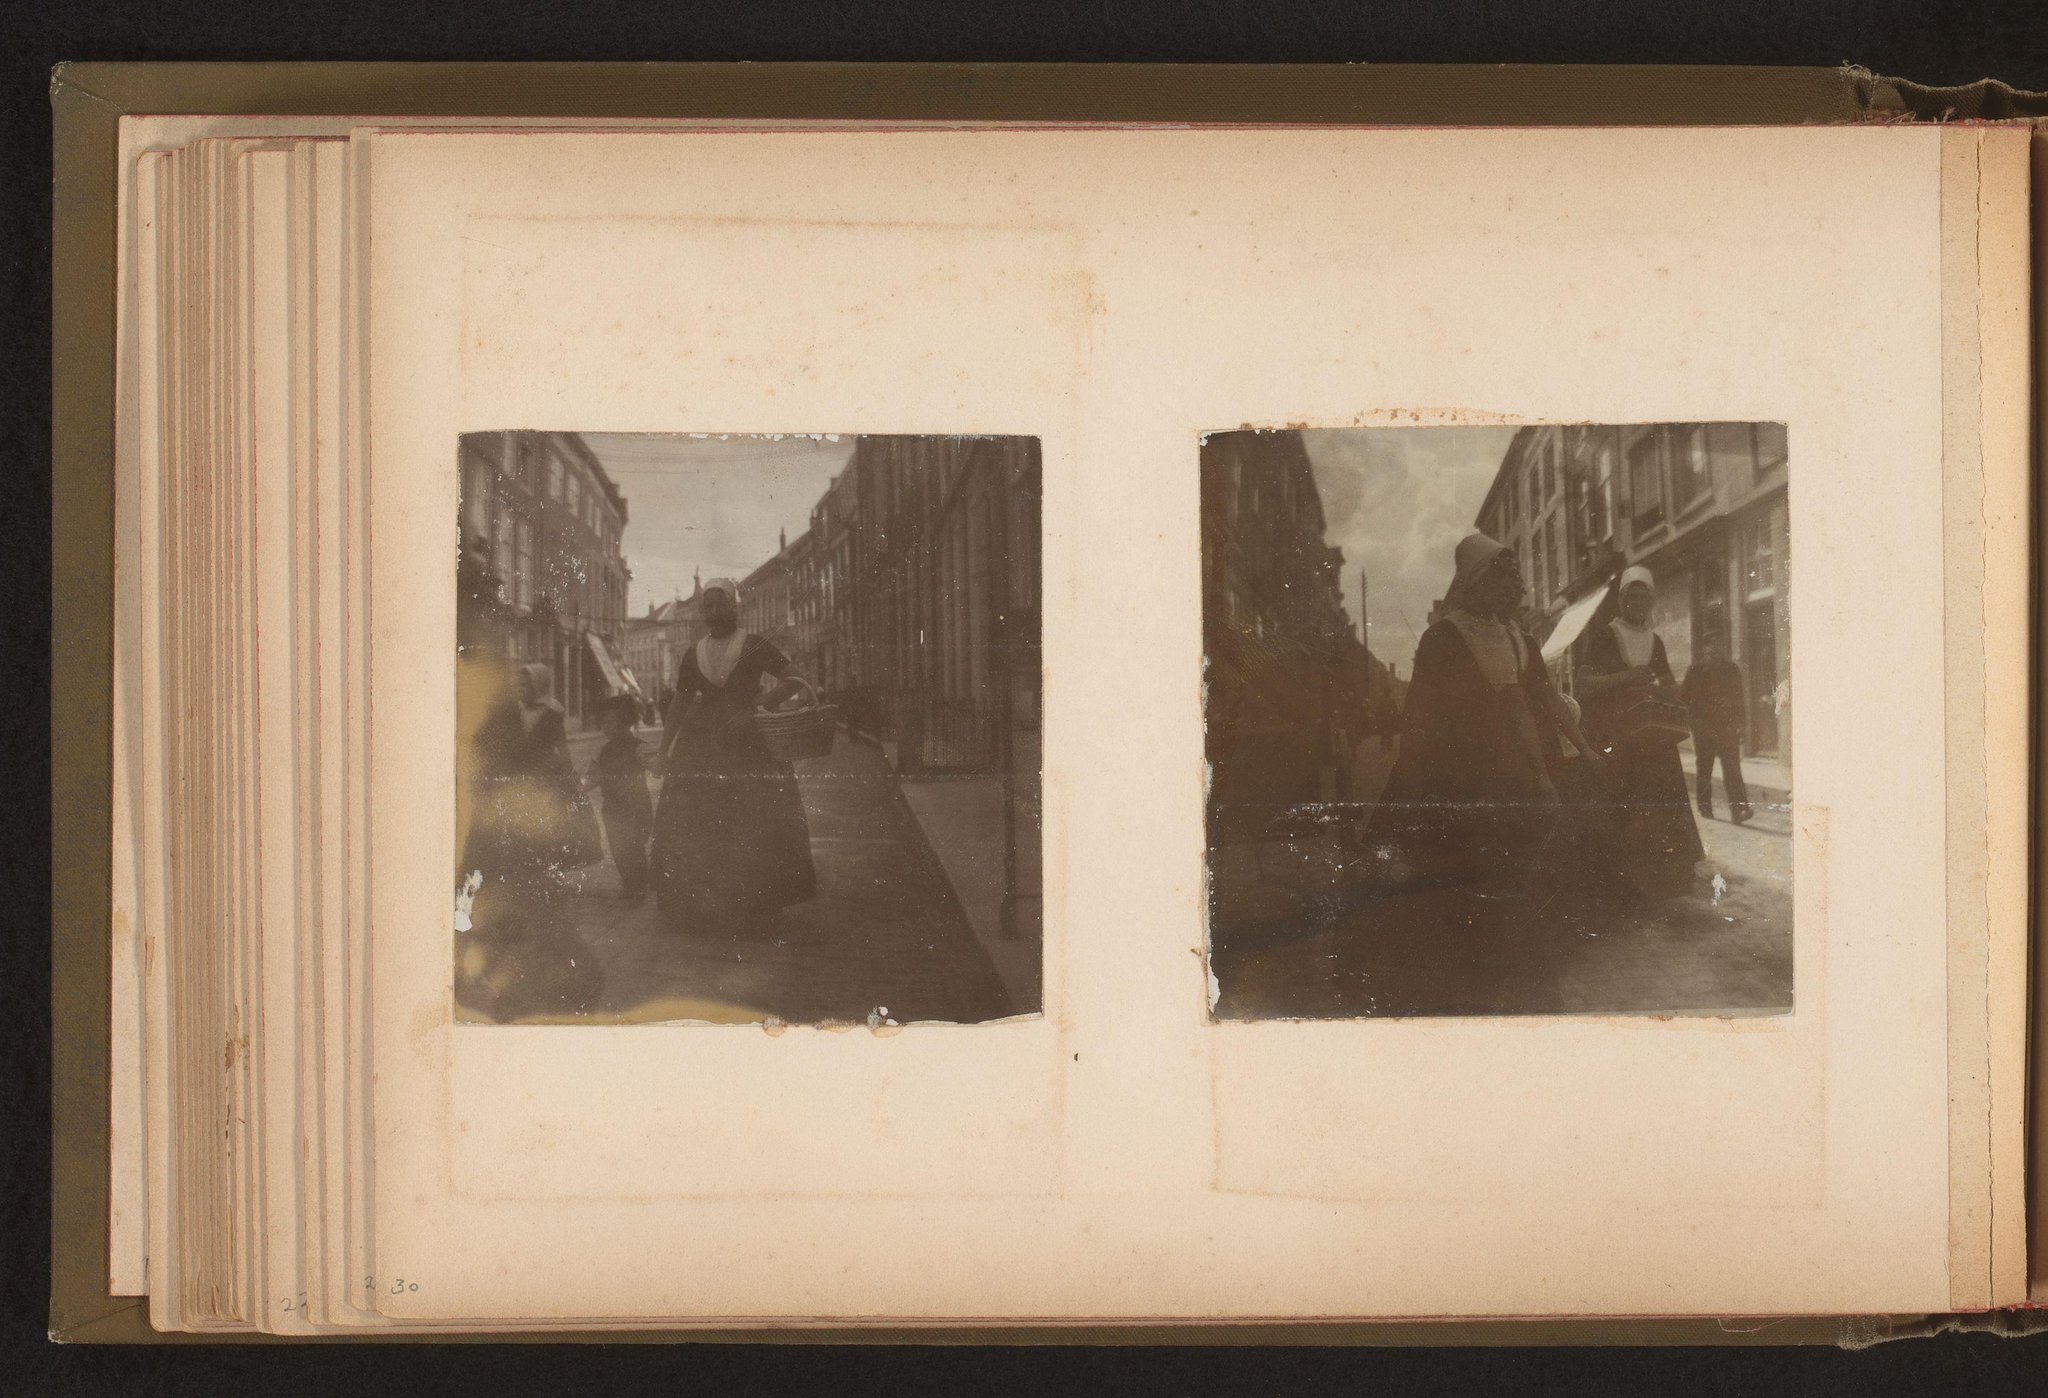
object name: album leaf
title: Twee foto's van vrouwen in klederdracht op straat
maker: Anonymous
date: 1895-1910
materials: paper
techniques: collodion silver print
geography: netherlands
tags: adult woman, folk costume, regional costume, netherlands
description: Deze foto's maken deel uit van een album.